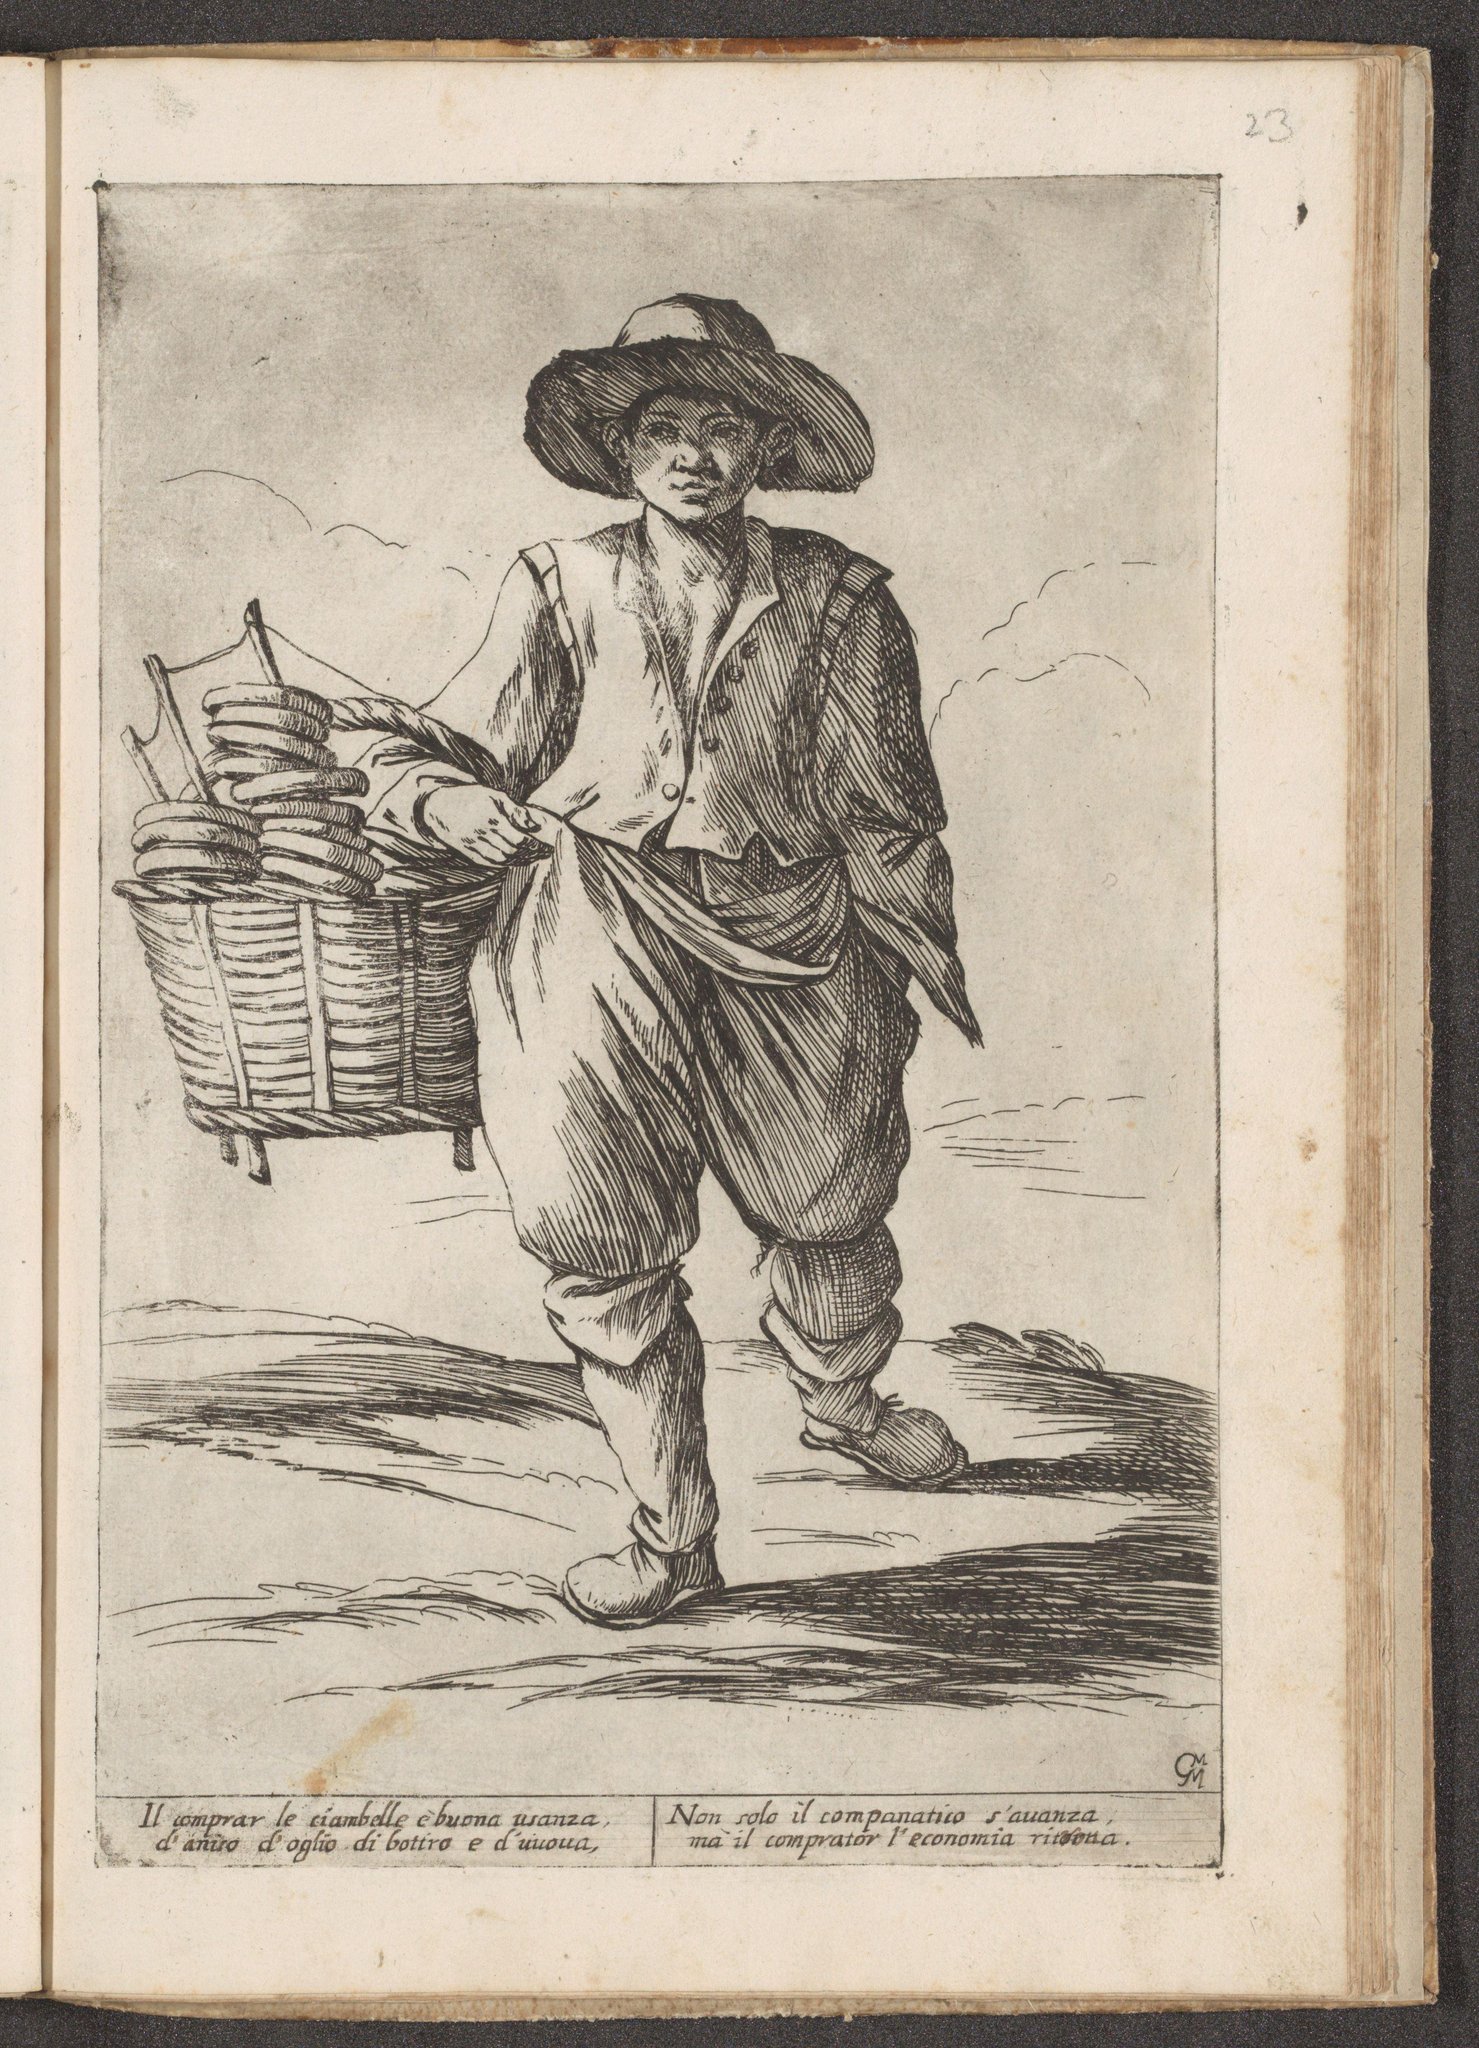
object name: print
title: Straatverkopers in Bologna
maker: giuseppe maria mitelli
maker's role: draughtsman, painter, print maker, publisher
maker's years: 1634-1718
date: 1660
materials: paper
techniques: etching, intaglio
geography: bologna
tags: bread, loaf, street-trader, 'cris de paris', cries of london, etc.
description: Een jongeman met aan zijn arm een mand met stokken met ciambelles, ringvormige broodjes. Italiaans vers in ondermarge. De prent maakt deel uit van een album.